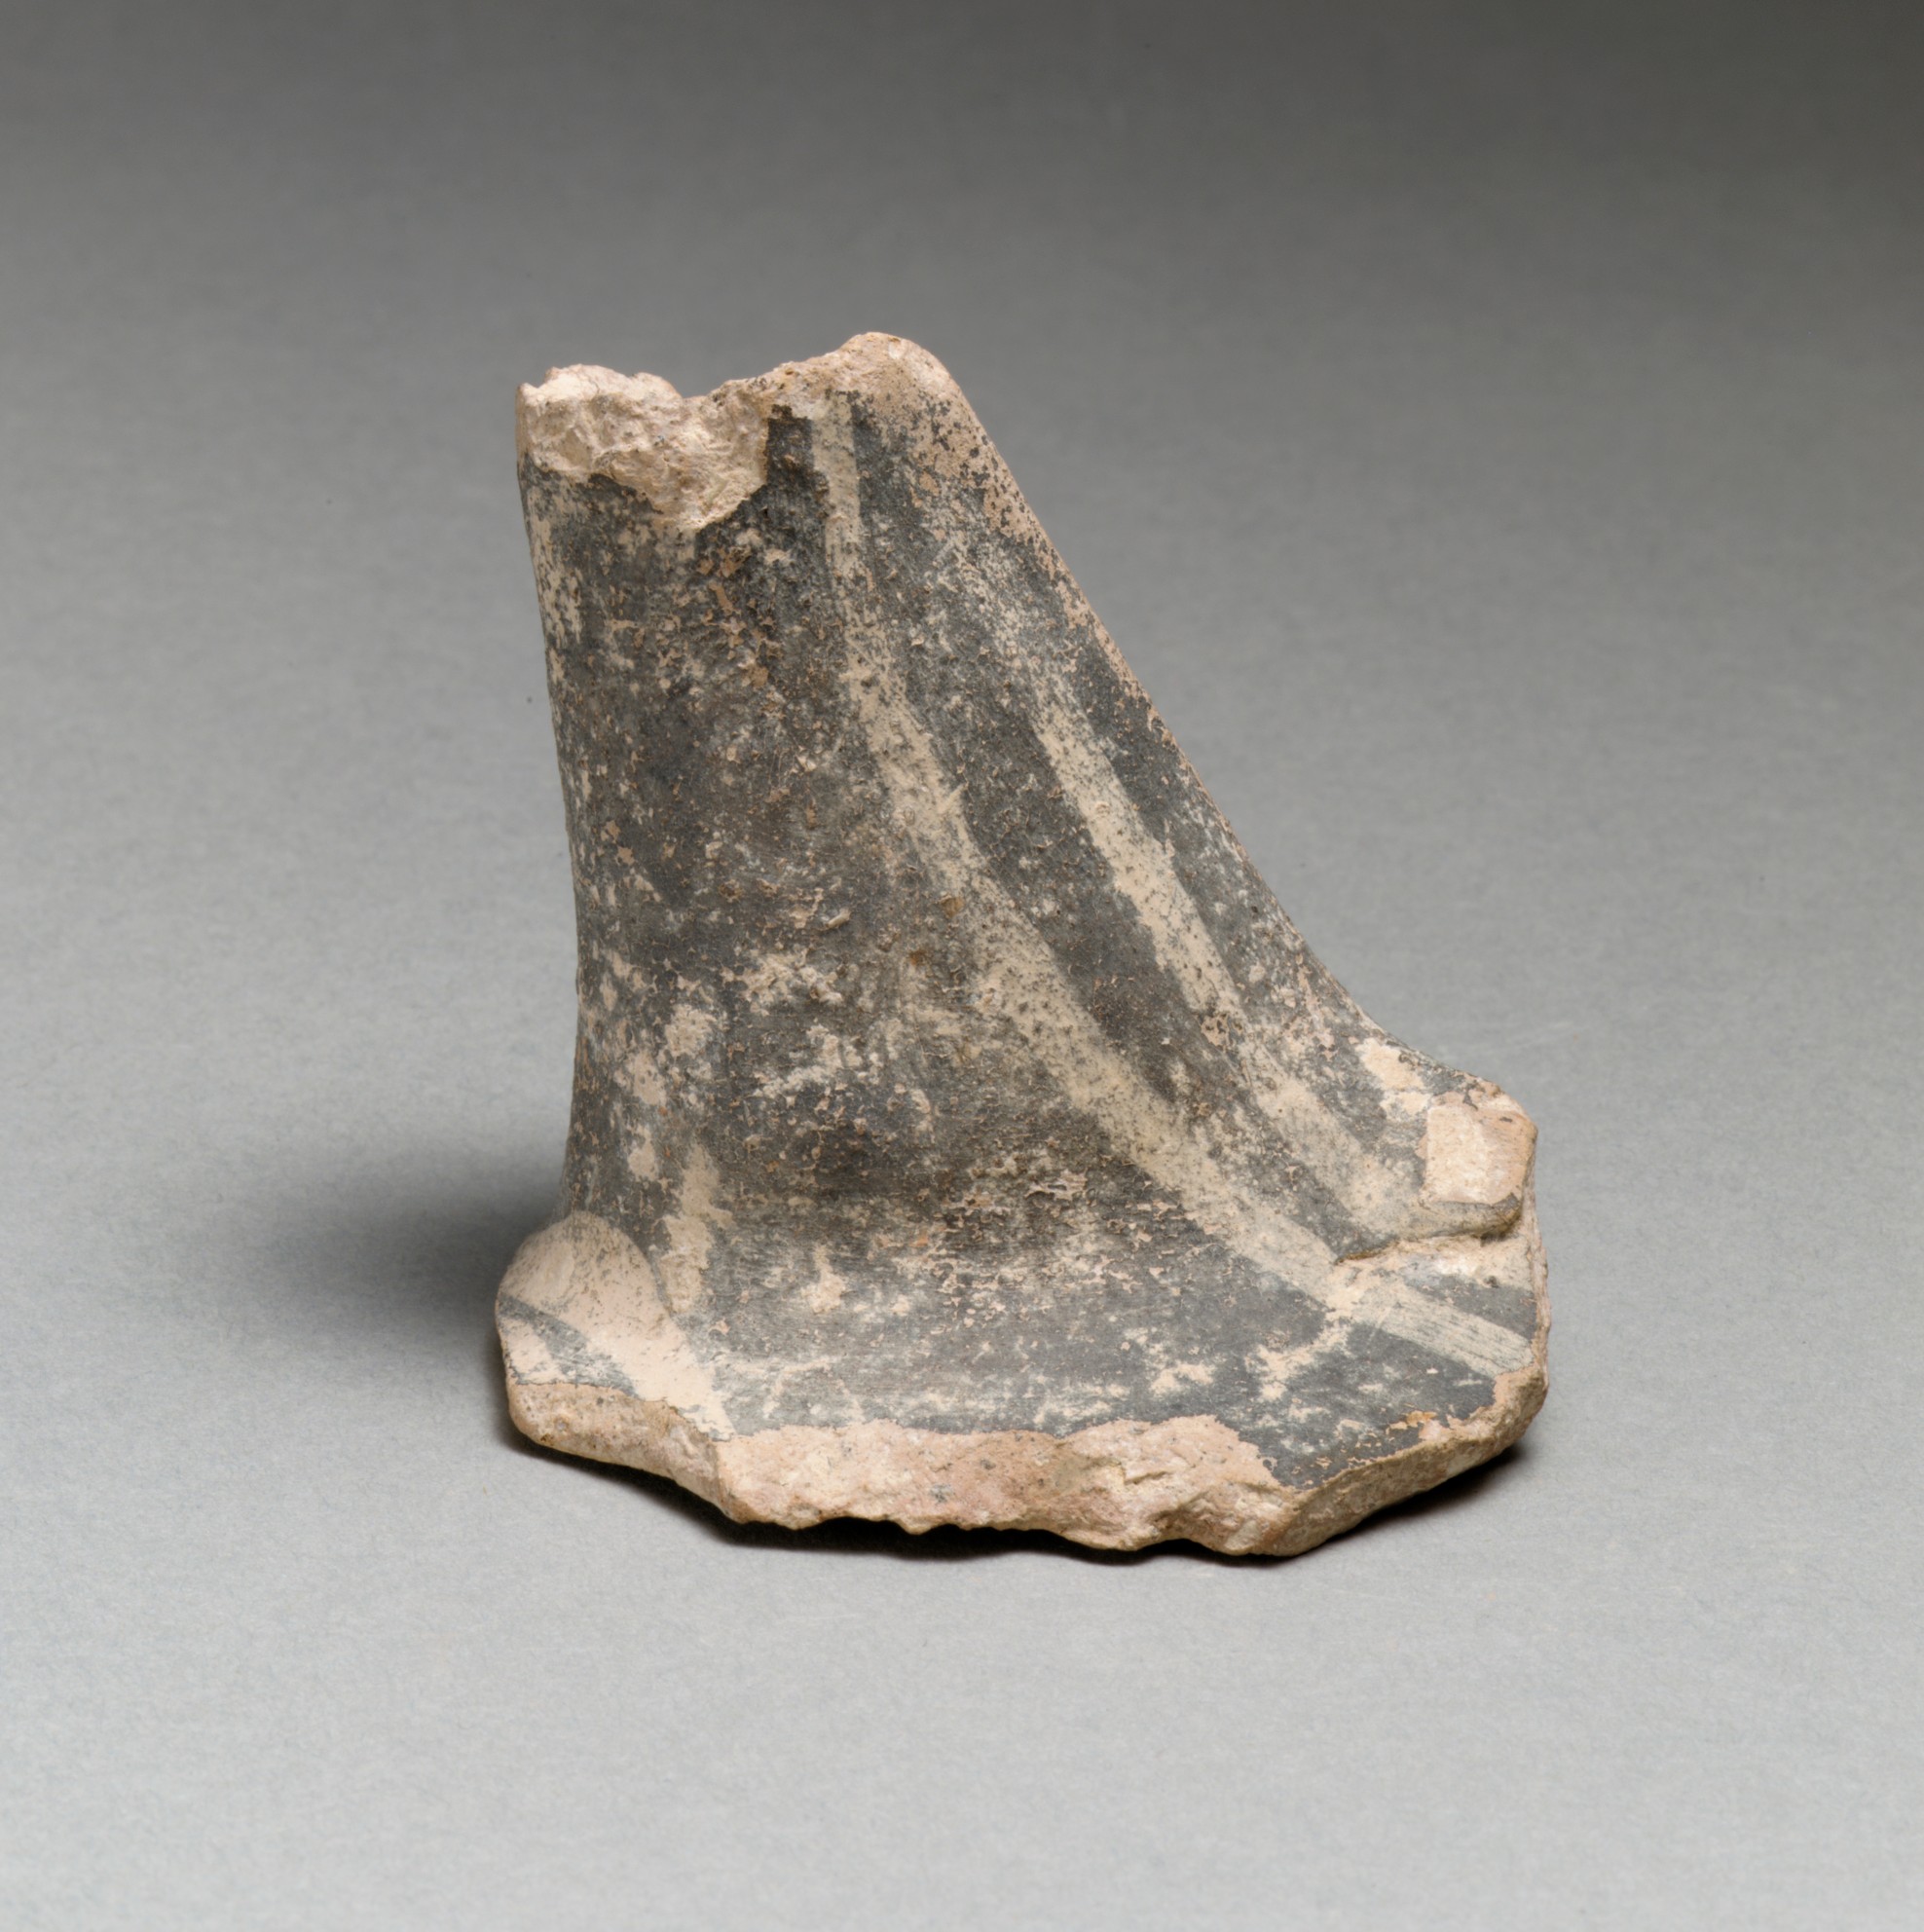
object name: vase fragment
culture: minoan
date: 2600-2000 BCE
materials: terracotta